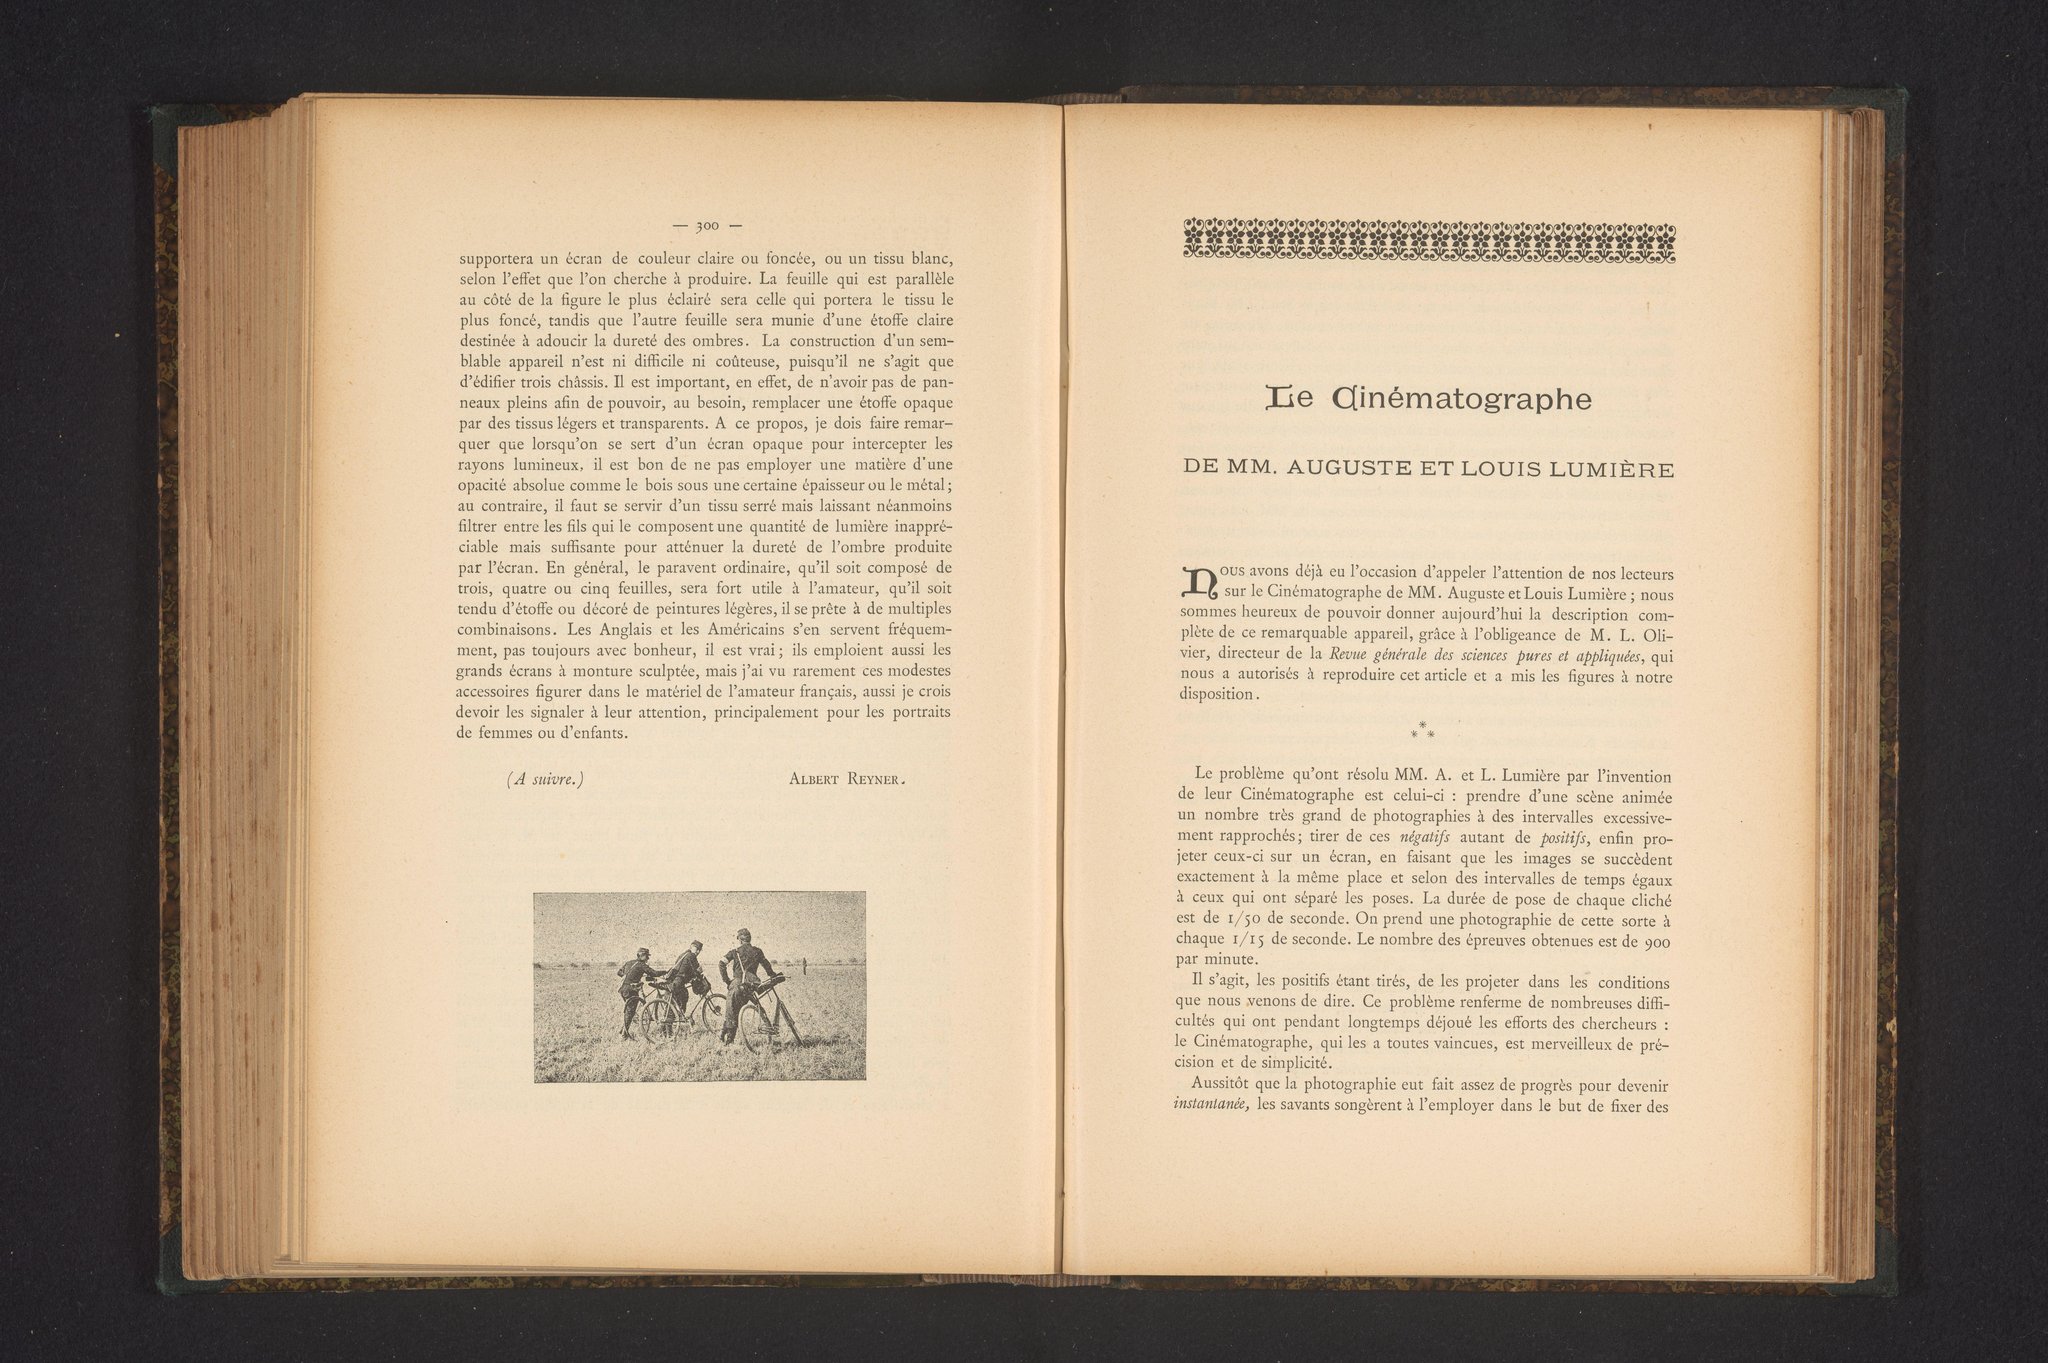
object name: page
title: Drie mannen in uniform met twee fietsen in een veld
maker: Anonymous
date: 1890-1895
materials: paper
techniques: photograph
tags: adult man, meadow, pasture, bicycle